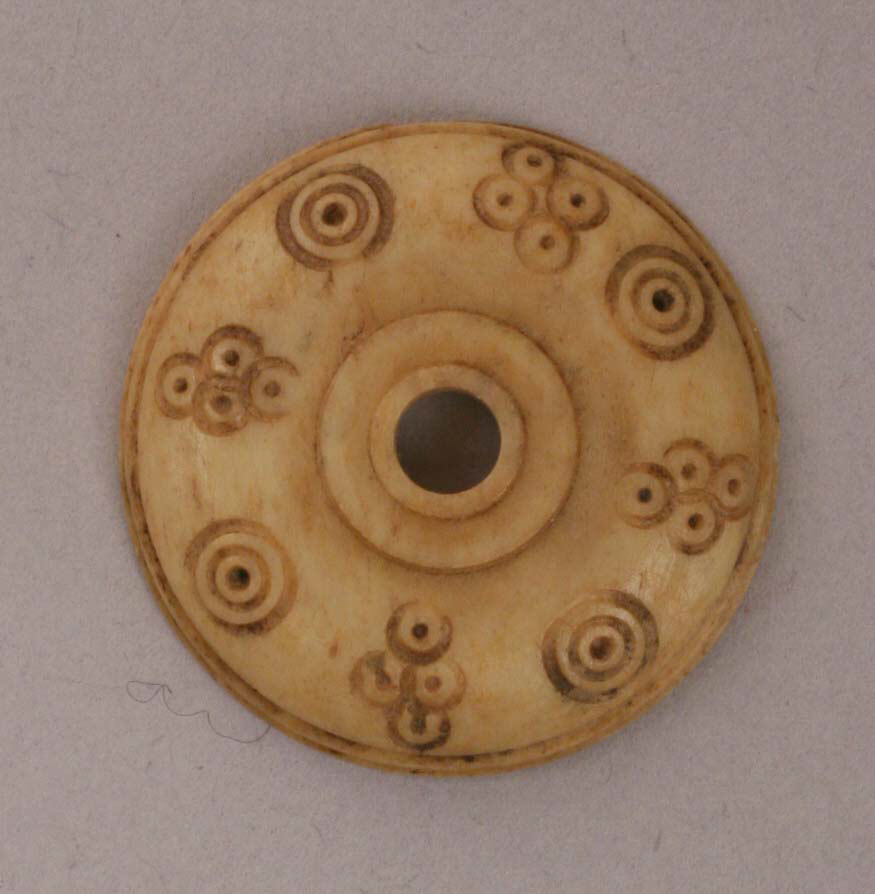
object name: button or bead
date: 801-1000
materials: bone, paint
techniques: incising, inlay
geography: iran